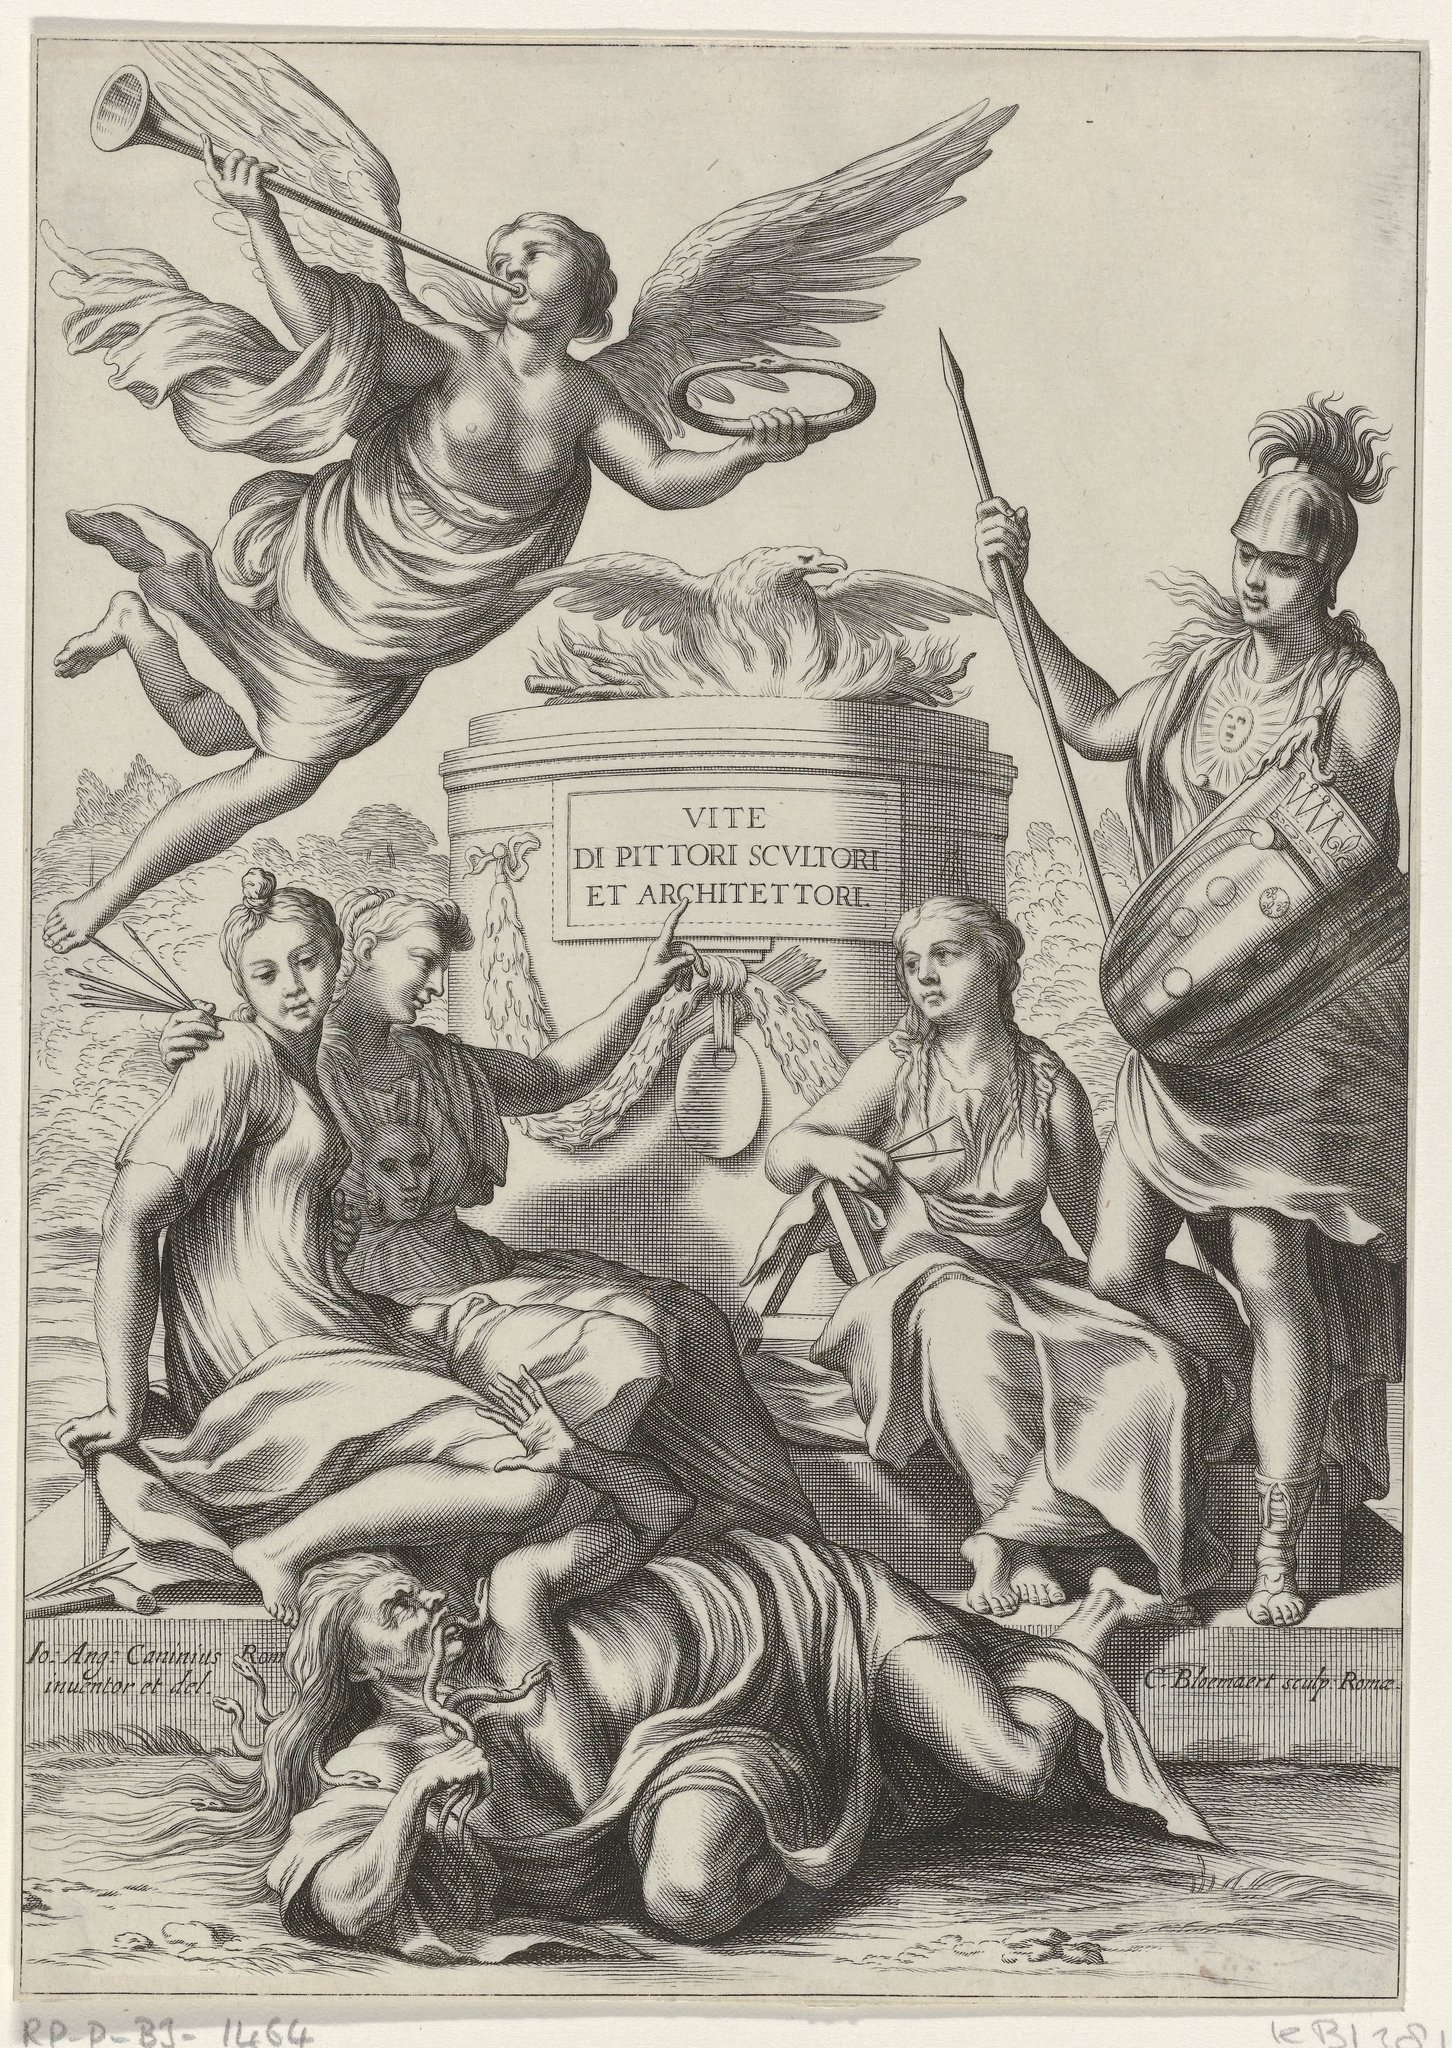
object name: print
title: Titelpagina voor Giovanni Battista, Le vite de' pittori, scvltori et architetti, Rome, 1642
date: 1642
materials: paper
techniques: engraving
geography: rome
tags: 'pictura', symbolic representations, allegories and emblems ~ painting; 'pittura' (ripa), 'sculptura', symbolic representations, allegories and emblems ~ sculpture; 'scoltura' (ripa), (story of) minerva (pallas, athena), 'architectura', symbolic representations, allegories and emblems ~ architecture; 'architettura' (ripa)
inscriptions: collector's mark: Lugt 240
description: Voor een sokkel zitten de personificaties van de schilderkunst, beeldhouwkunst en architectuur. Op de sokkel zit een adelaar op een vuur. Naast de personificaties staat Minerva de beschermvrouw van de kunsten. Op de grond kruipt de Afgunst, slangen groeien uit haar vingers en haar.